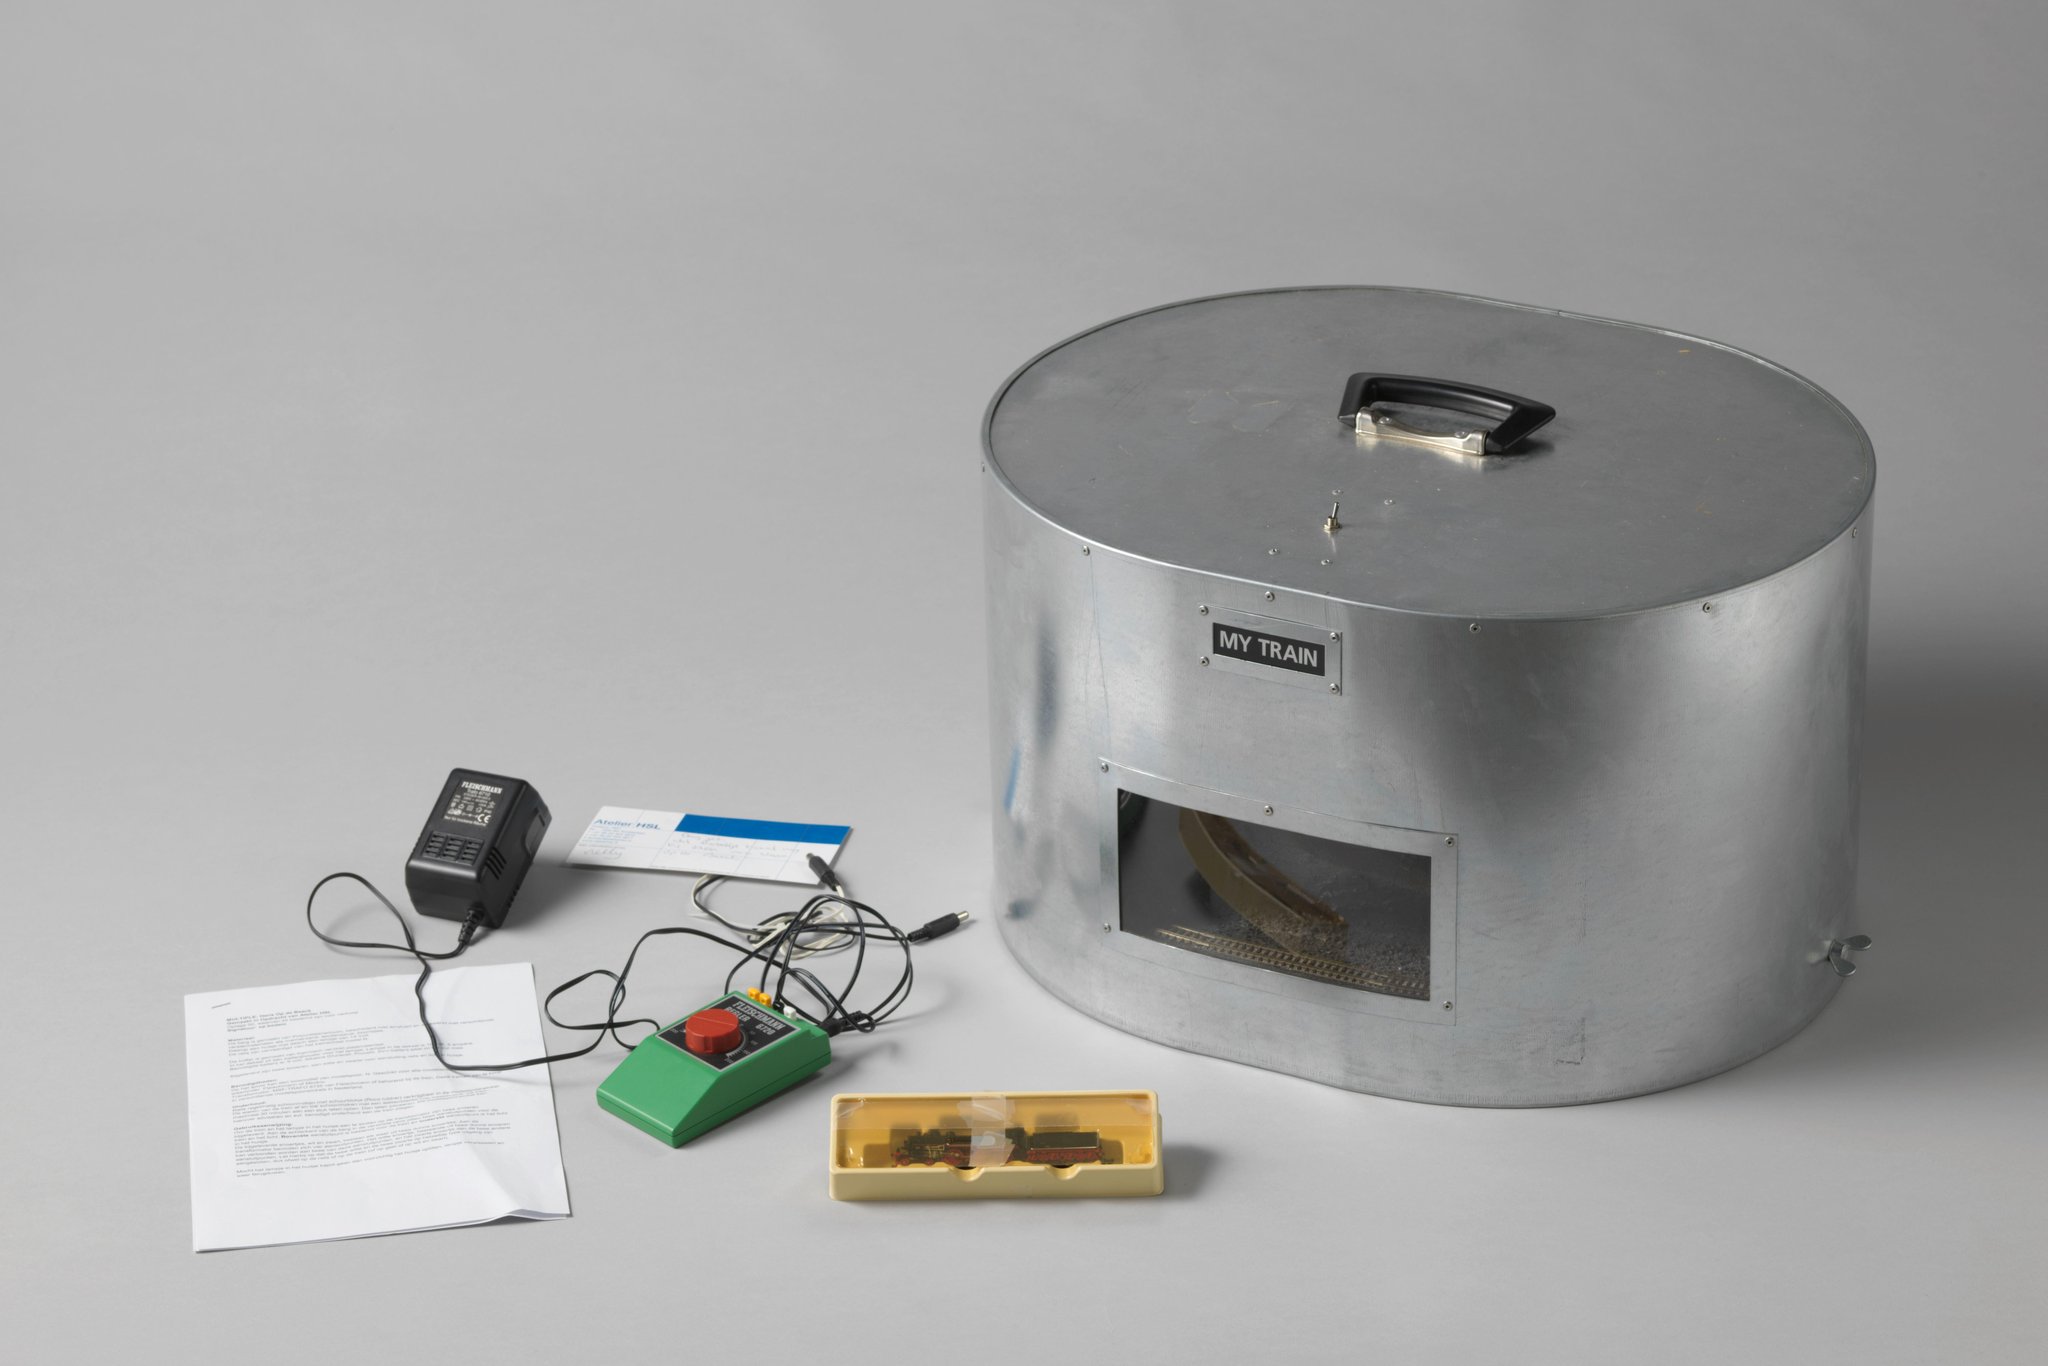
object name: model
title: My train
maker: hans op de beeck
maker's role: installatie-kunstenaar, videokunstenaar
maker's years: 1969-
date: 2002-2003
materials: metal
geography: netherlands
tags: netherlands, france, belgium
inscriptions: : ‘My train’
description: Draagbaar model spoorlandschap geïnspireerd op de Hoge Snelheidslijn van Amsterdam naar Parijs. Rond een rotspartij rijdt een trein in eindeloze rondjes. Het geheel wordt afgedekt door een zilverkleurige "Beautycase" van aluminium (NG-2008-28-8-A). Met opschrift. Gemaakt in opdracht van Atelier HSL.